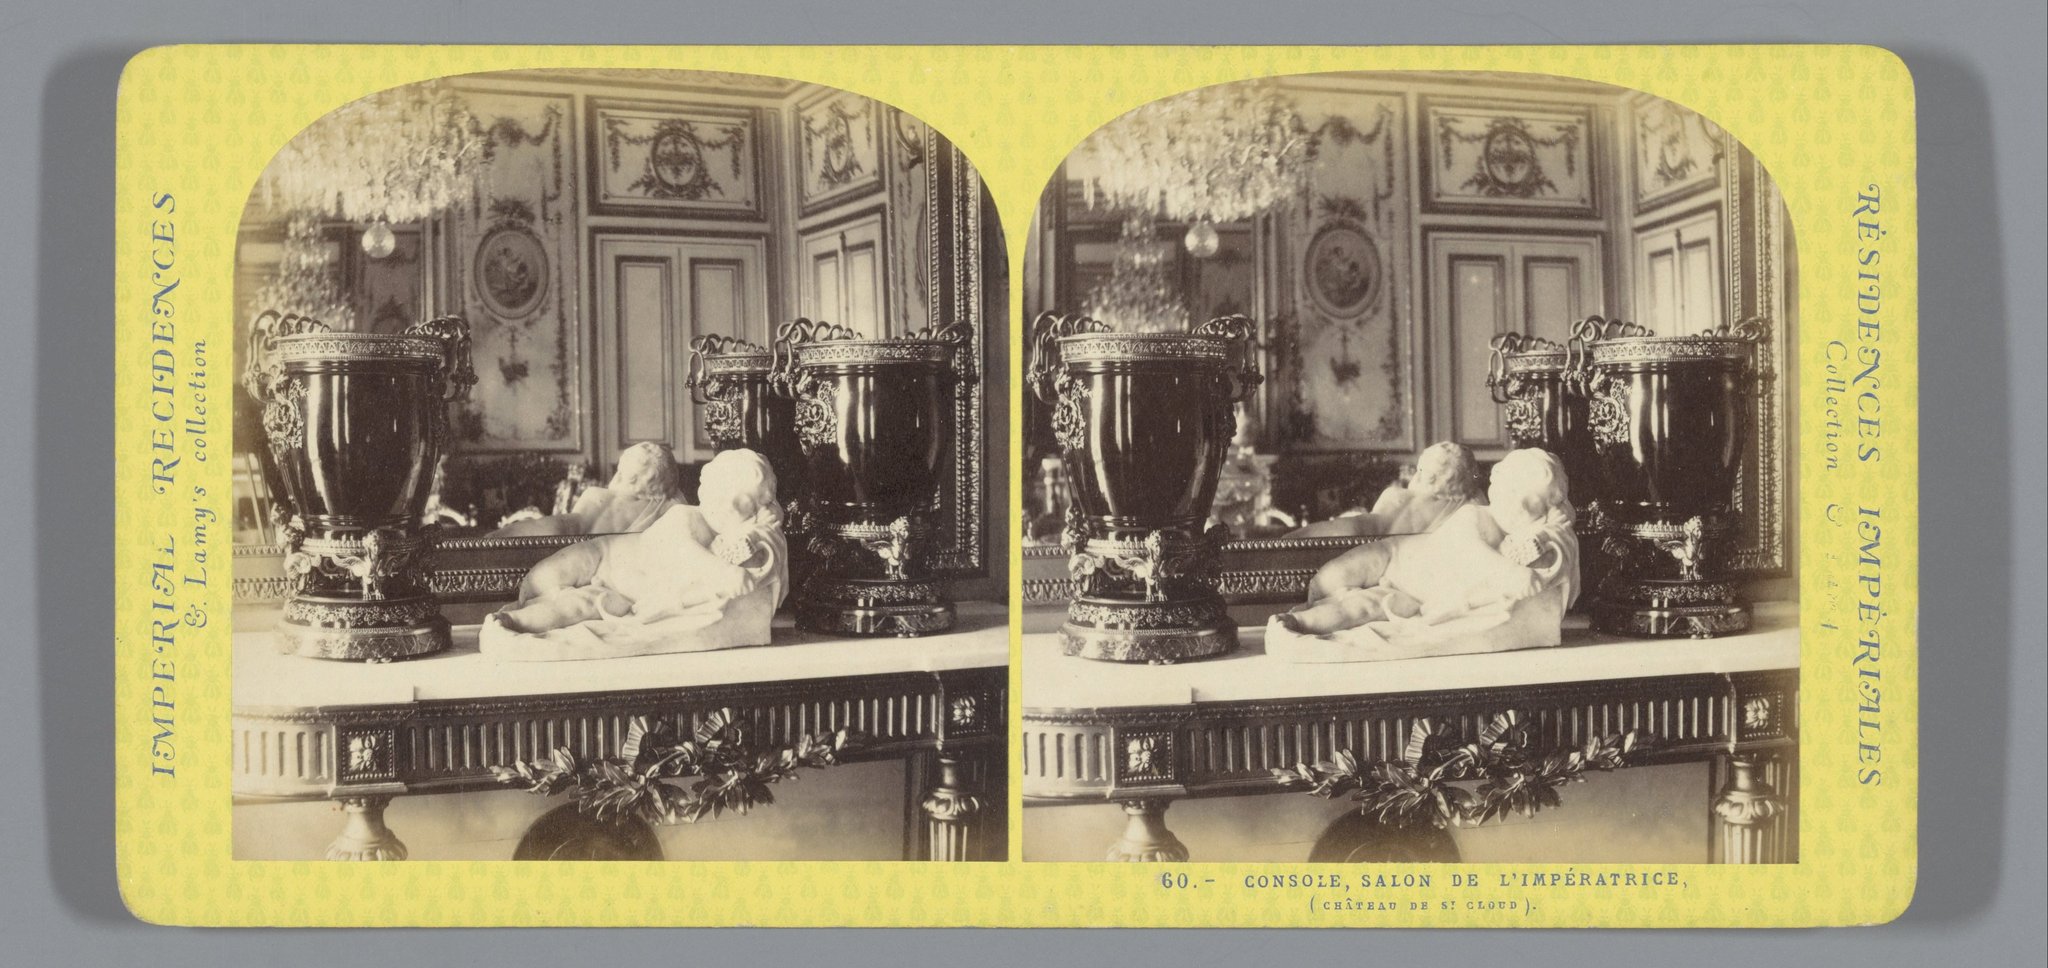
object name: stereograph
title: Console, Salon de l'Imperatrice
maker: ernest eléonor pierre lamy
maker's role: publisher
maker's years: 1828-1900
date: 1860-1870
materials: cardboard, photographic support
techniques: albumen print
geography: château de saint-cloud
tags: open hearth, fire-place, interior ~ representation of a building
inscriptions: inscription: ‘E. Lamy's collection’, number: ‘60.’